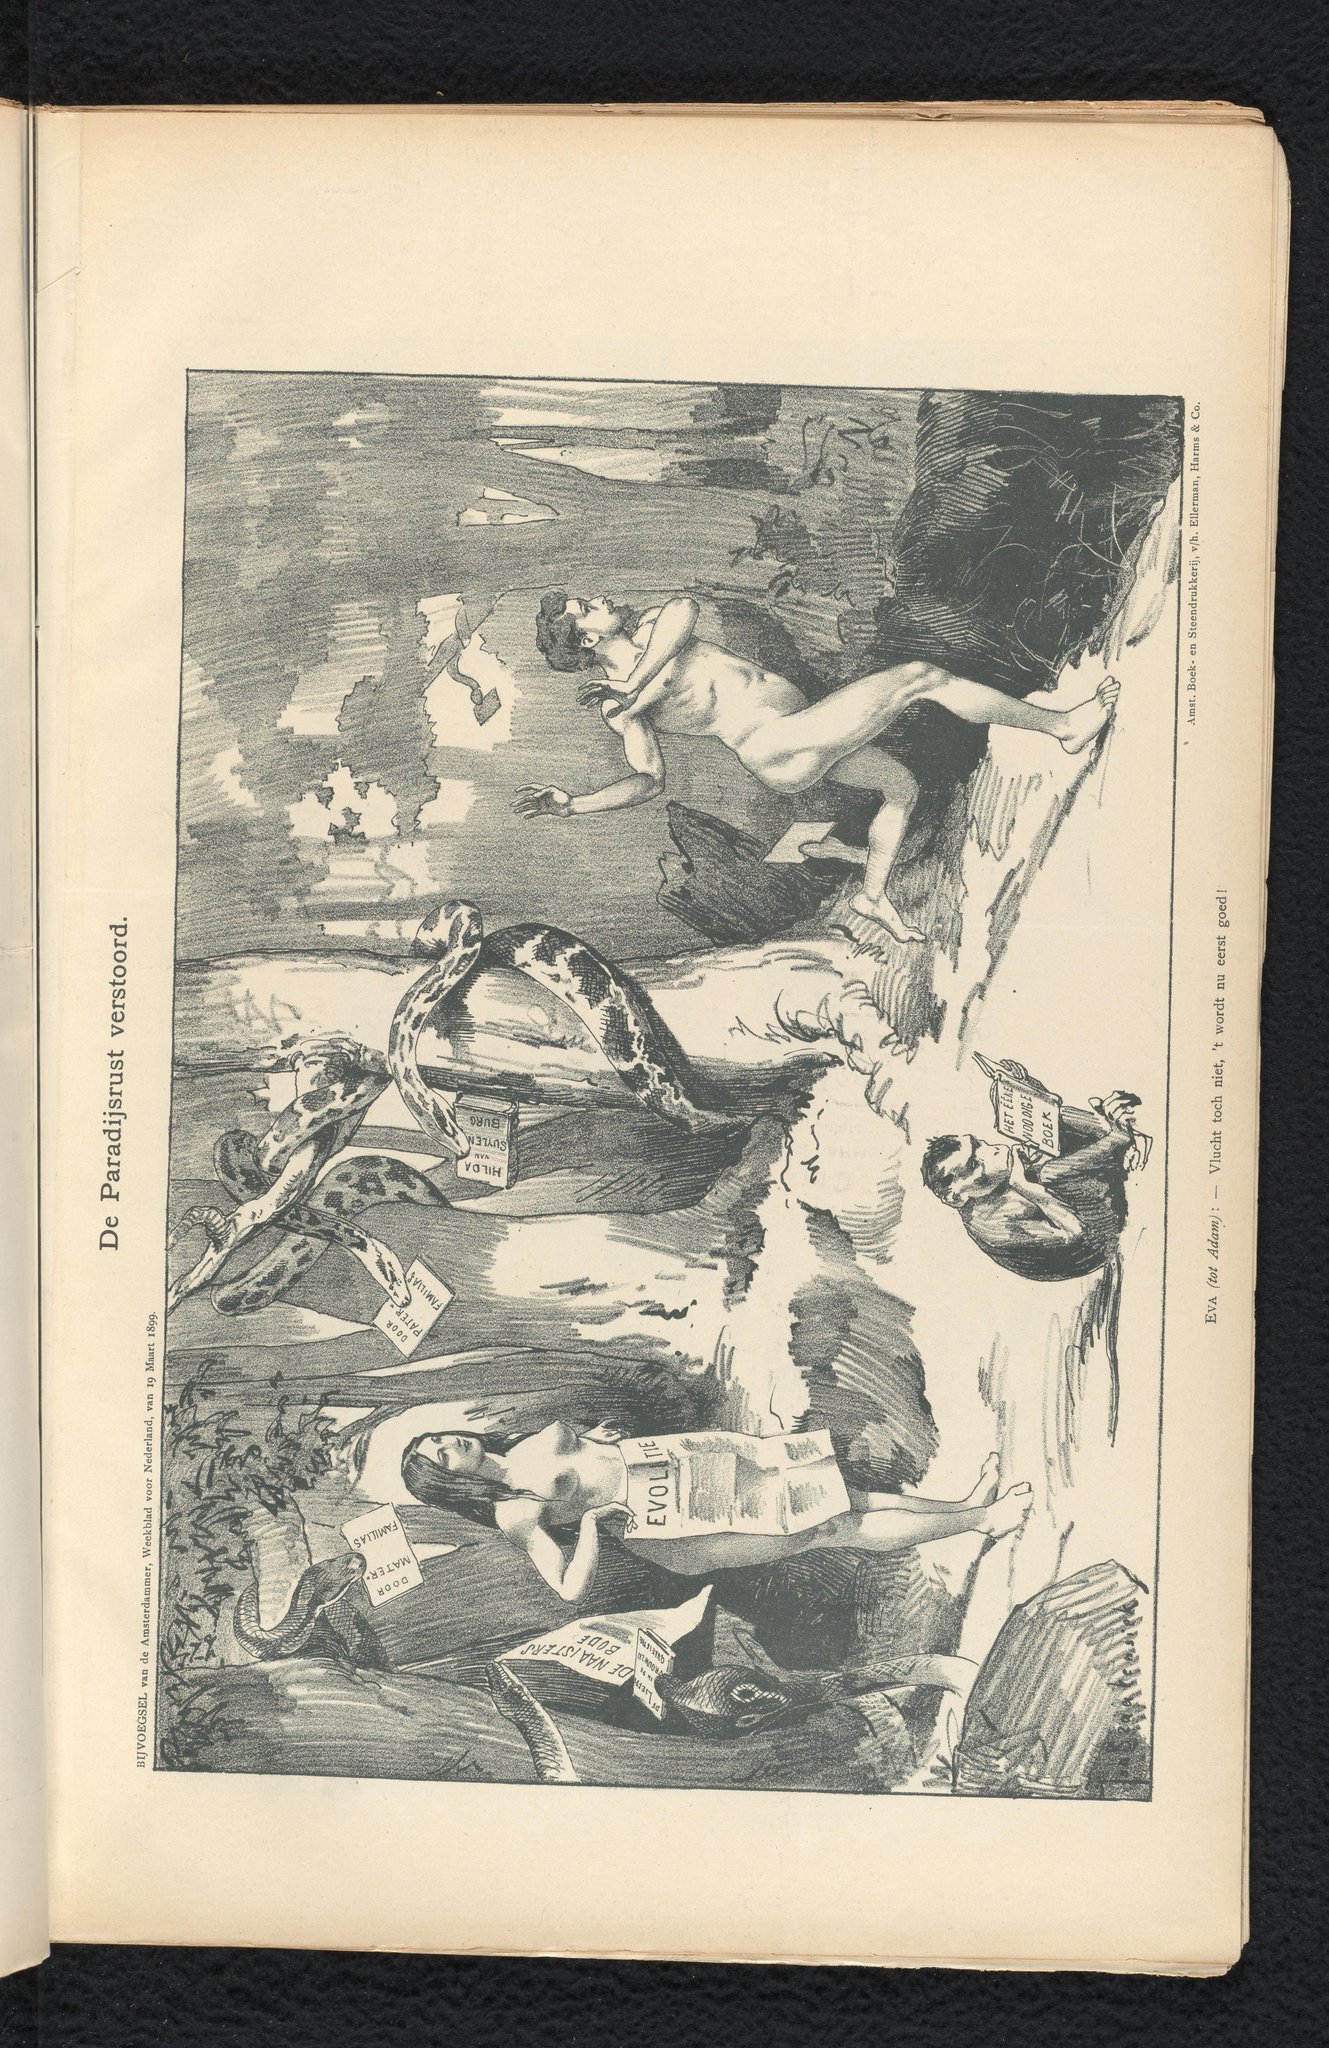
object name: cartoon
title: De Paradijsrust verstoord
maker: johan braakensiek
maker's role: draughtsman, print maker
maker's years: 1858-1940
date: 1899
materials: paper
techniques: lithograph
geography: netherlands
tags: snakes, reading, adam and eve in paradise (before the fall), monkeys, apes, evolution, man in flight (one-sided courting), political caricatures and satires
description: In een pastiche op de zondeval vlucht een naakte man (Adam) voor de verleiding van een naakte vrouw (Eva) die zich slechts deels bedekt met een blad papier met het opschrift 'Evolutie'. In de bomen meerdere slangen met feministische werken in de bek, waaronder de feministische roman uit 1897 'Hilda van Suylenburg' (geschreven door Cécile de Jong van Beek en Donk) en 'De Naaistersbode', het officiële orgaan van de Algemeene Nederlandsche Naaistersbond (ANNB). Op de voorgrond een lezende aap verdiept in 'Het ééne noodige boek'.